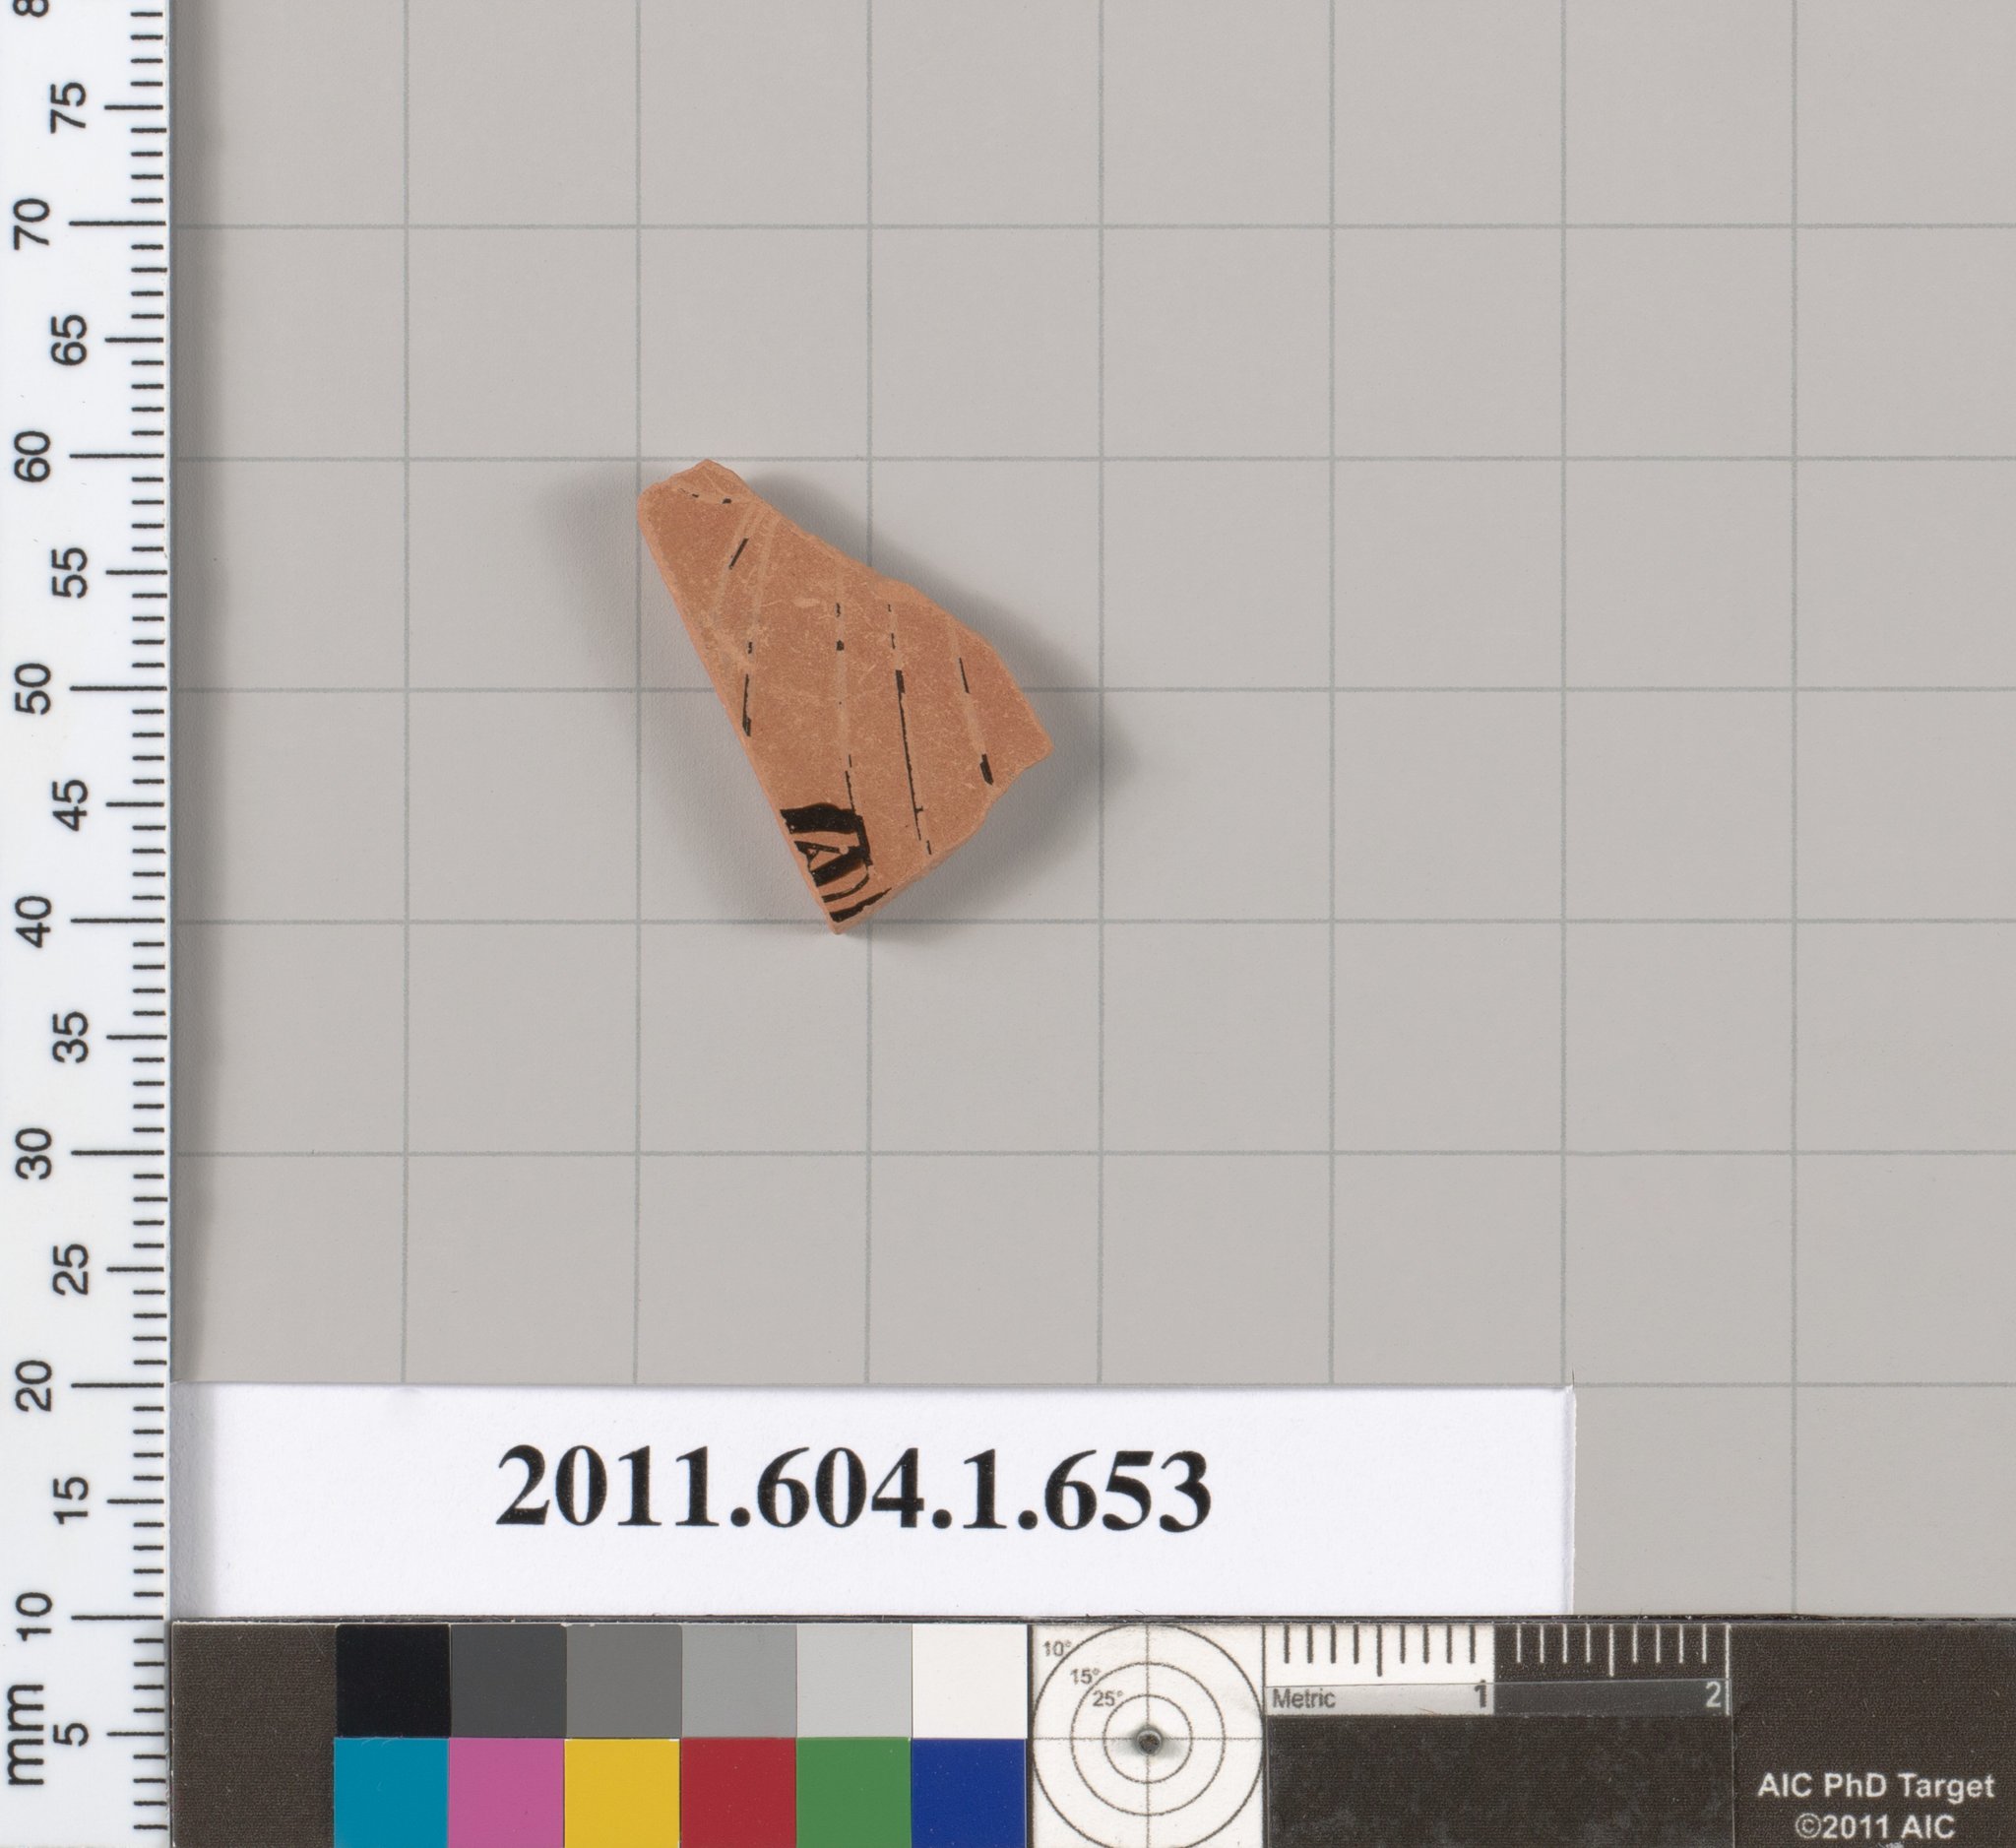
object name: kylix fragment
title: Terracotta fragment of a kylix (drinking cup)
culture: greek, attic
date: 475-451 BCE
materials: terracotta